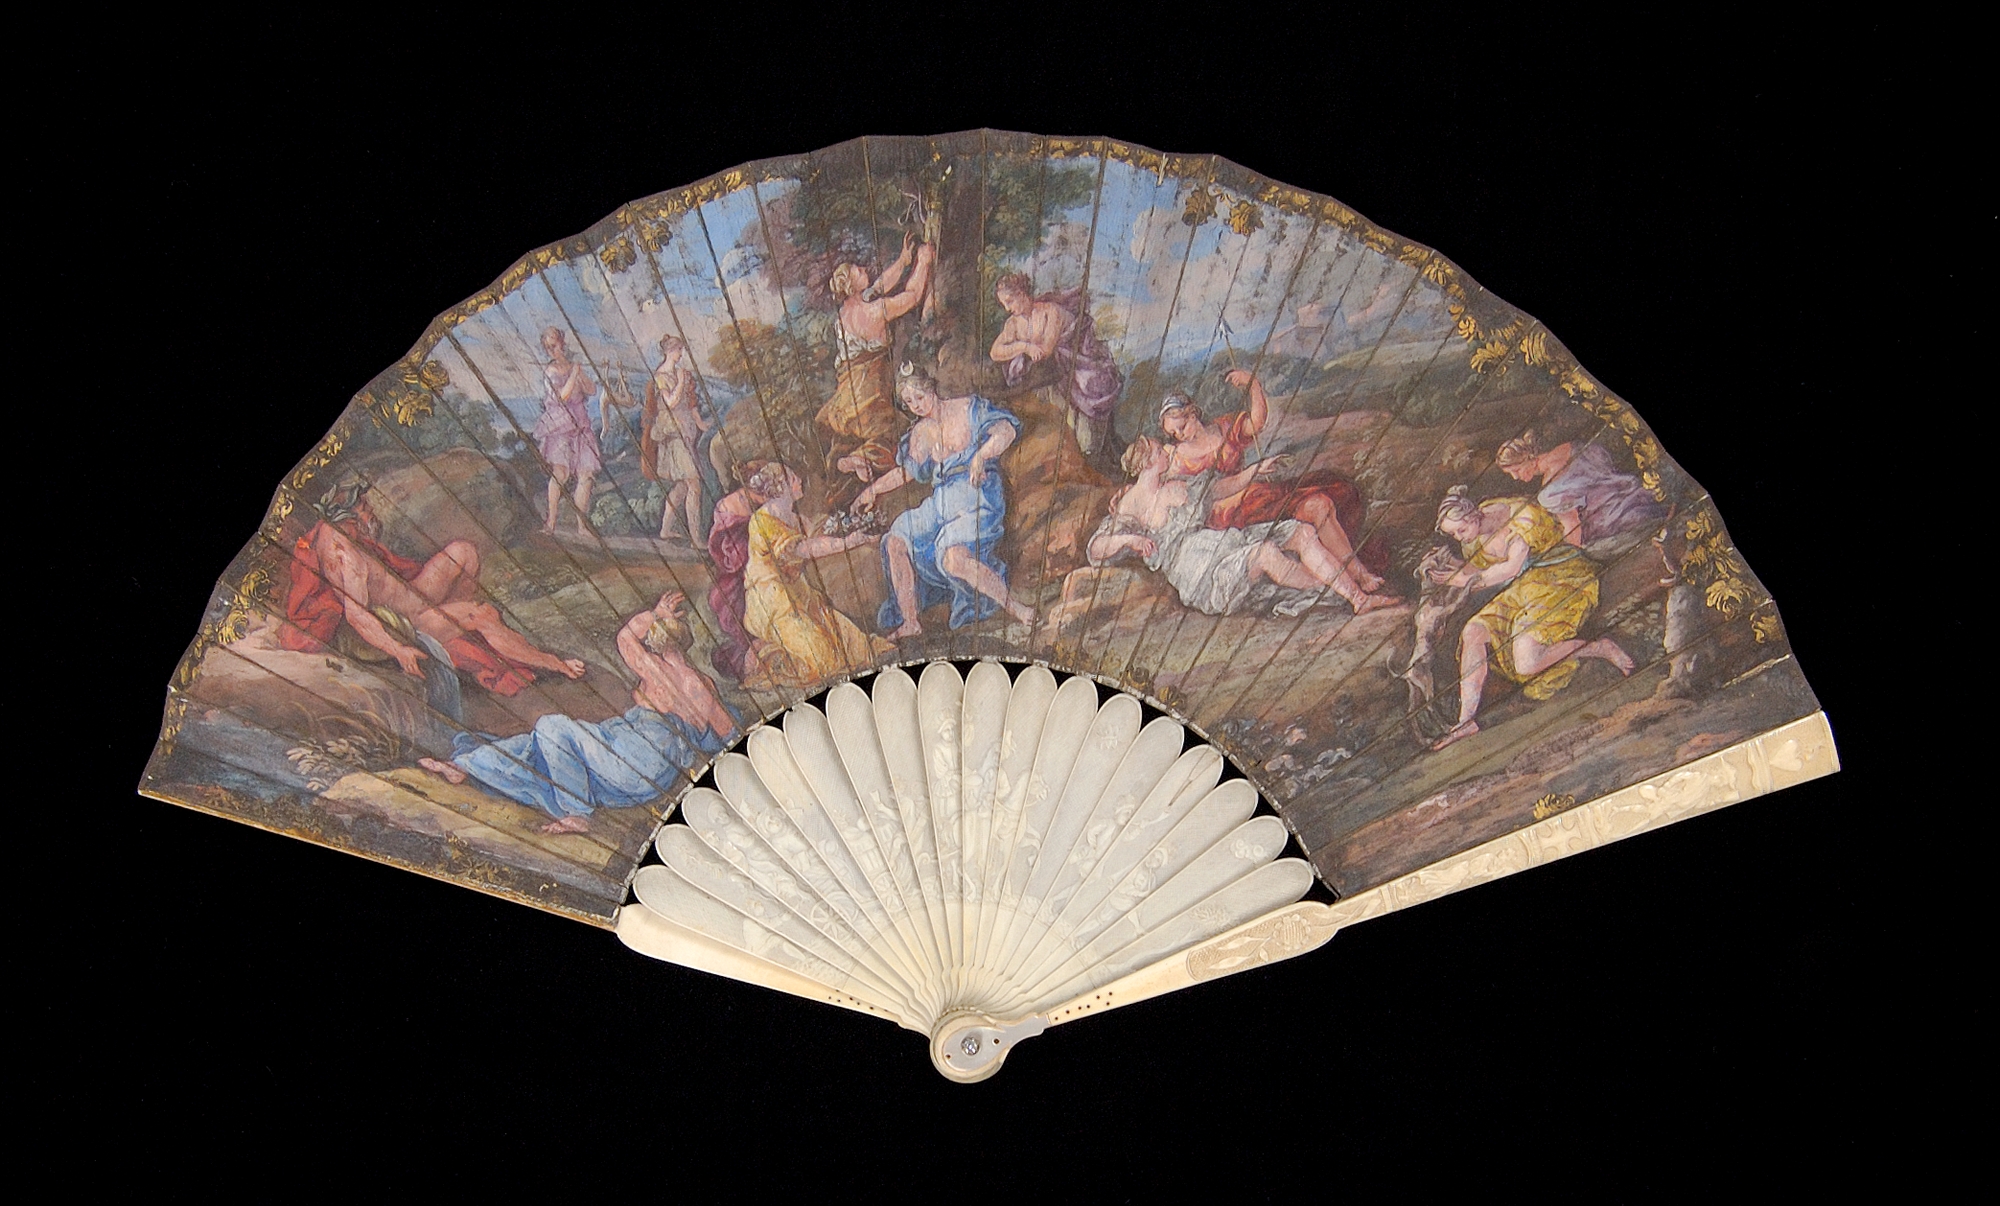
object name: fan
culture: european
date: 1826-1850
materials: ivory, mother of pearl, paper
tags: male nudes,women,dogs